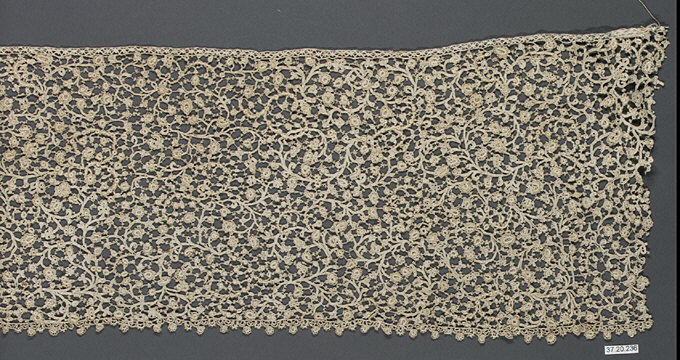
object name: flounce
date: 1701-1733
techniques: lace